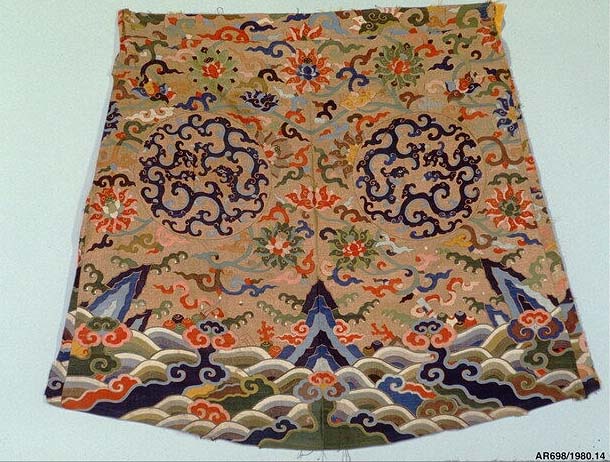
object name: robe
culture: tibetan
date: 1601-1700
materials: gold leaf, metal, silk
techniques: tapestry